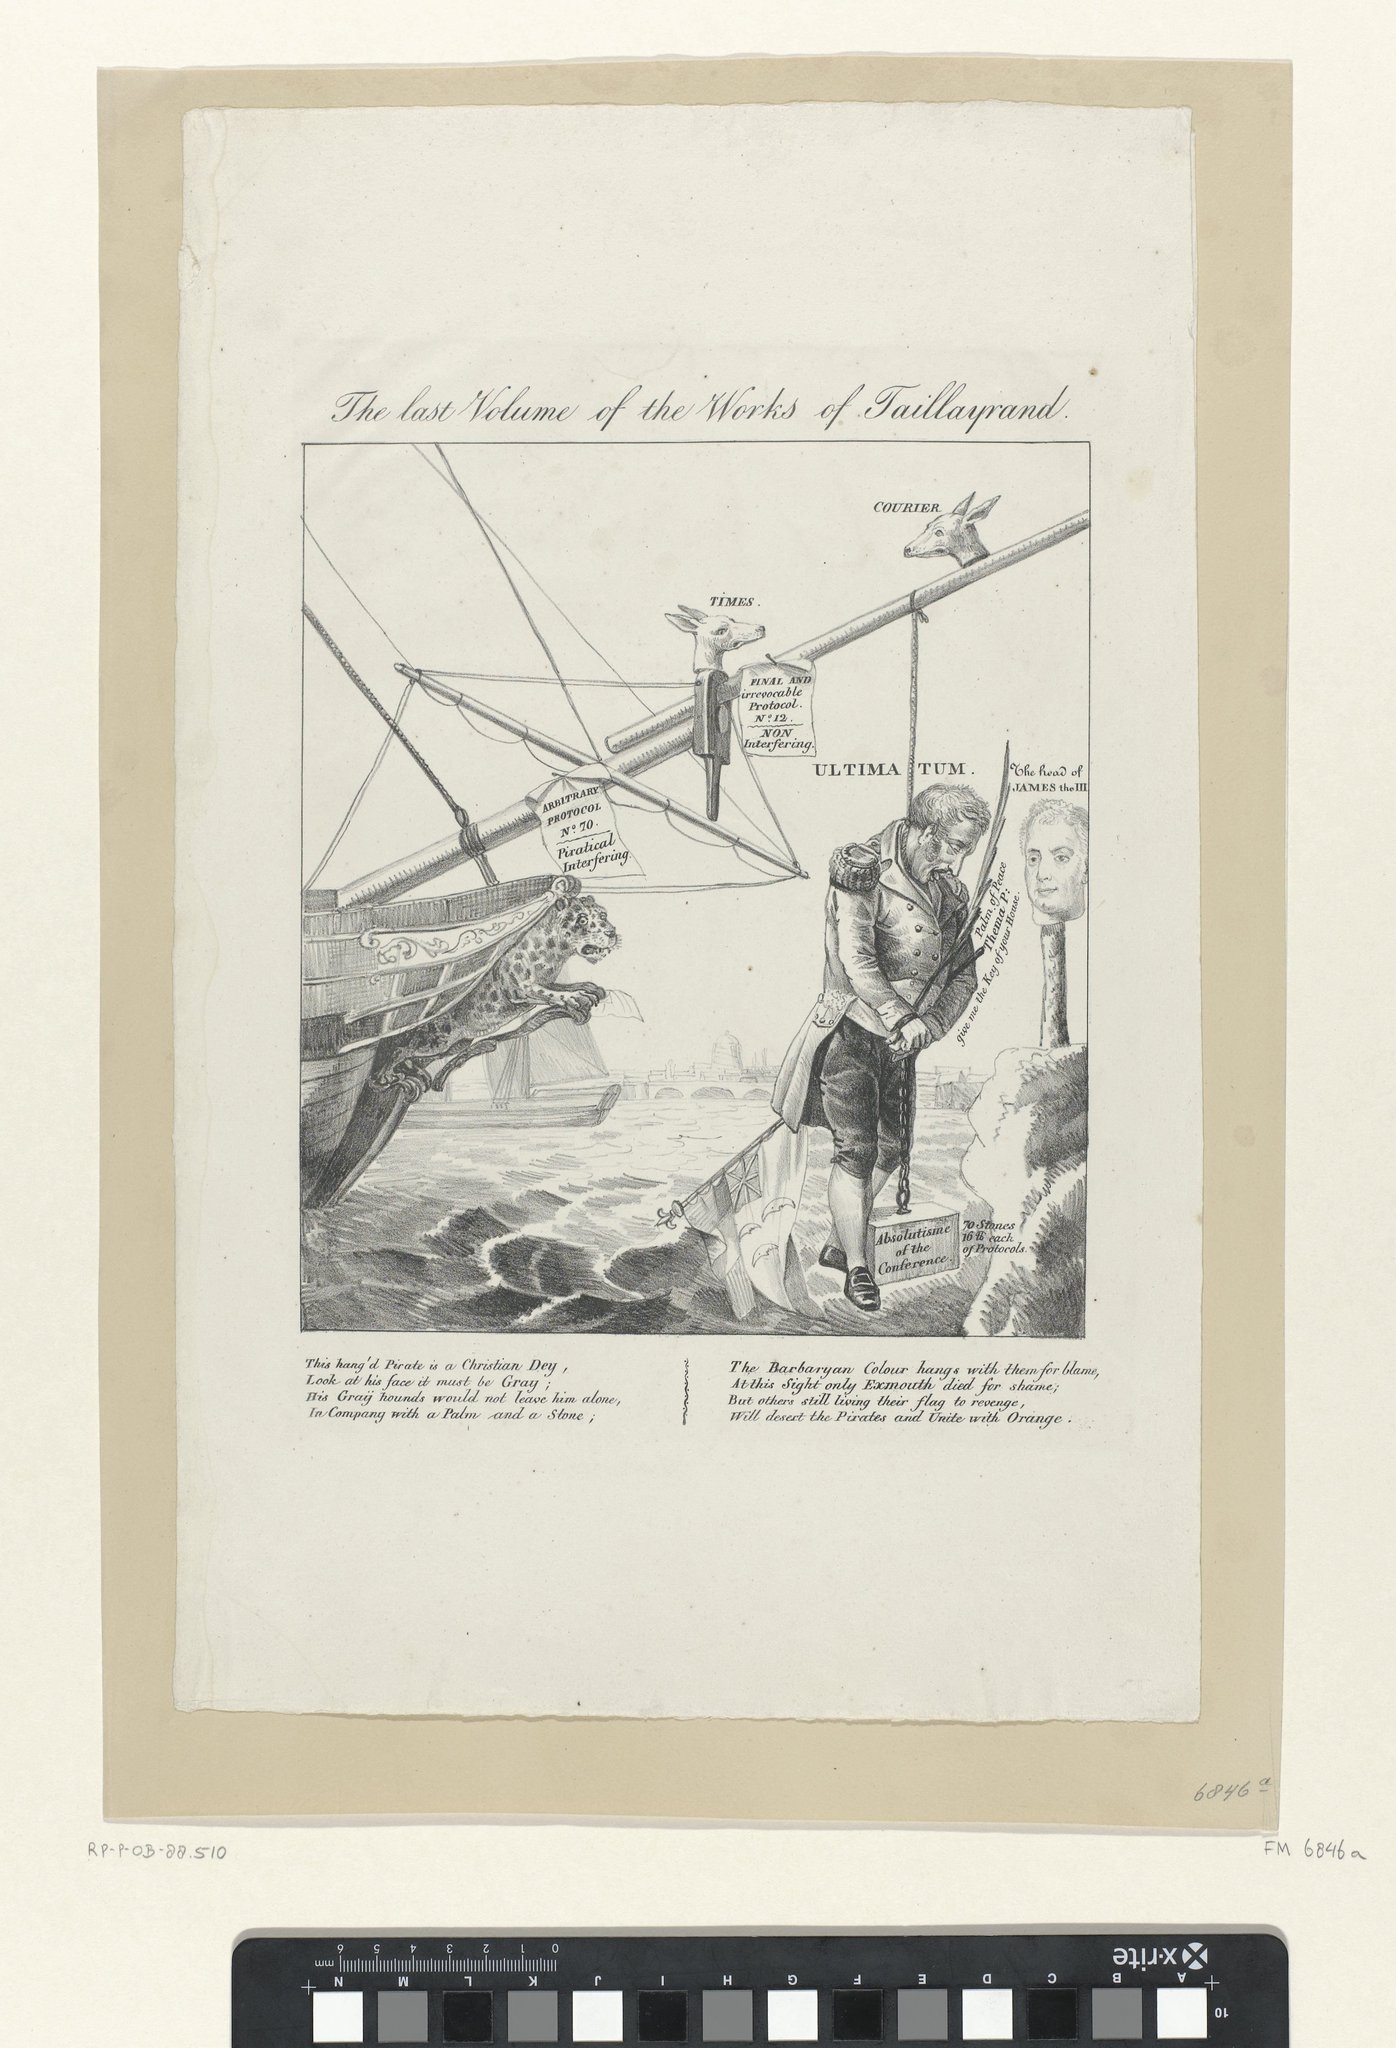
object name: print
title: The last Volume of the Works of Taillayrand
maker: Anonymous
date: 1832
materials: paper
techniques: lithograph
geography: great britain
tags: politician, charles maurice hertog van talleyrand-périgord, violent death by hanging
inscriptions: collector's mark: Lugt 2228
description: Spotprent op de te pro-Franse Britse houding tijdens de onderhandelingen tijdens de Conferentie van Londen over de onafhankelijkheid van België, 22 oktober 1832. De Britse premier Earl Grey is opgehangen aan de boegspriet van een Engels schip. In zijn handen een palm en een ketting met steen, een verwijzing naar Lord Palmerston, de minister van buitenlandse zaken in Greys kabinet. Aan de spriet de afgehakte koppen van twee hazewindhonden, de kranten Times en Courier, en twee protocollen. Rechts op de wal het afgehakte hoofd van koning Jacobus III (=II). Onderaan twee vierregelige verzen in het Engels waarin gepleit wordt voor meer steun voor Oranje (Nederland).